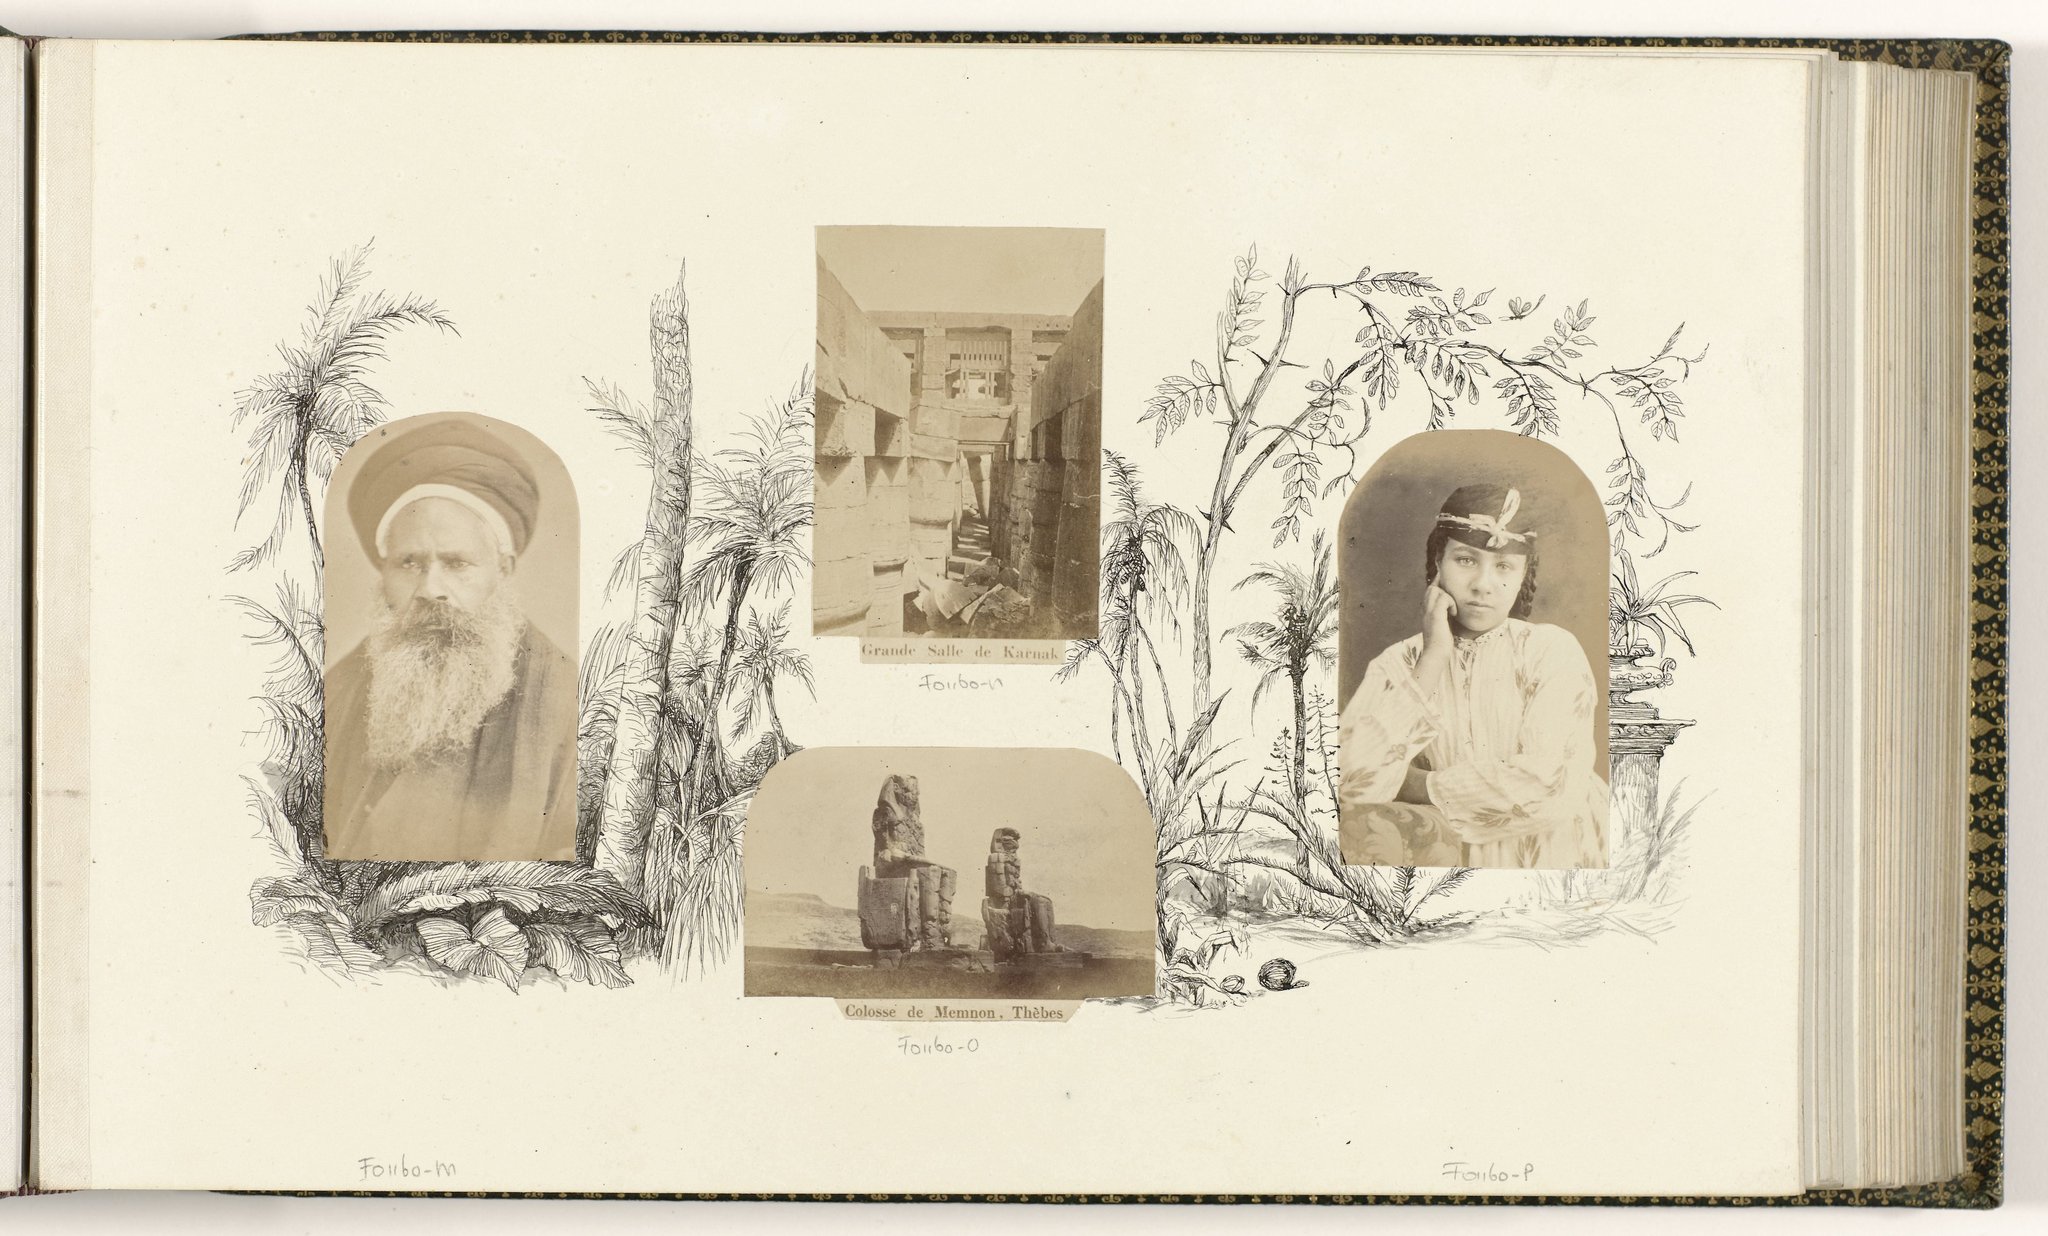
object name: album leaf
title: Grande salle de Karnak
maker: Anonymous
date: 1865-1875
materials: paper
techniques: albumen print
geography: karnak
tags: temple, shrine ~ egyptian religion, ruin of a building ~ architecture